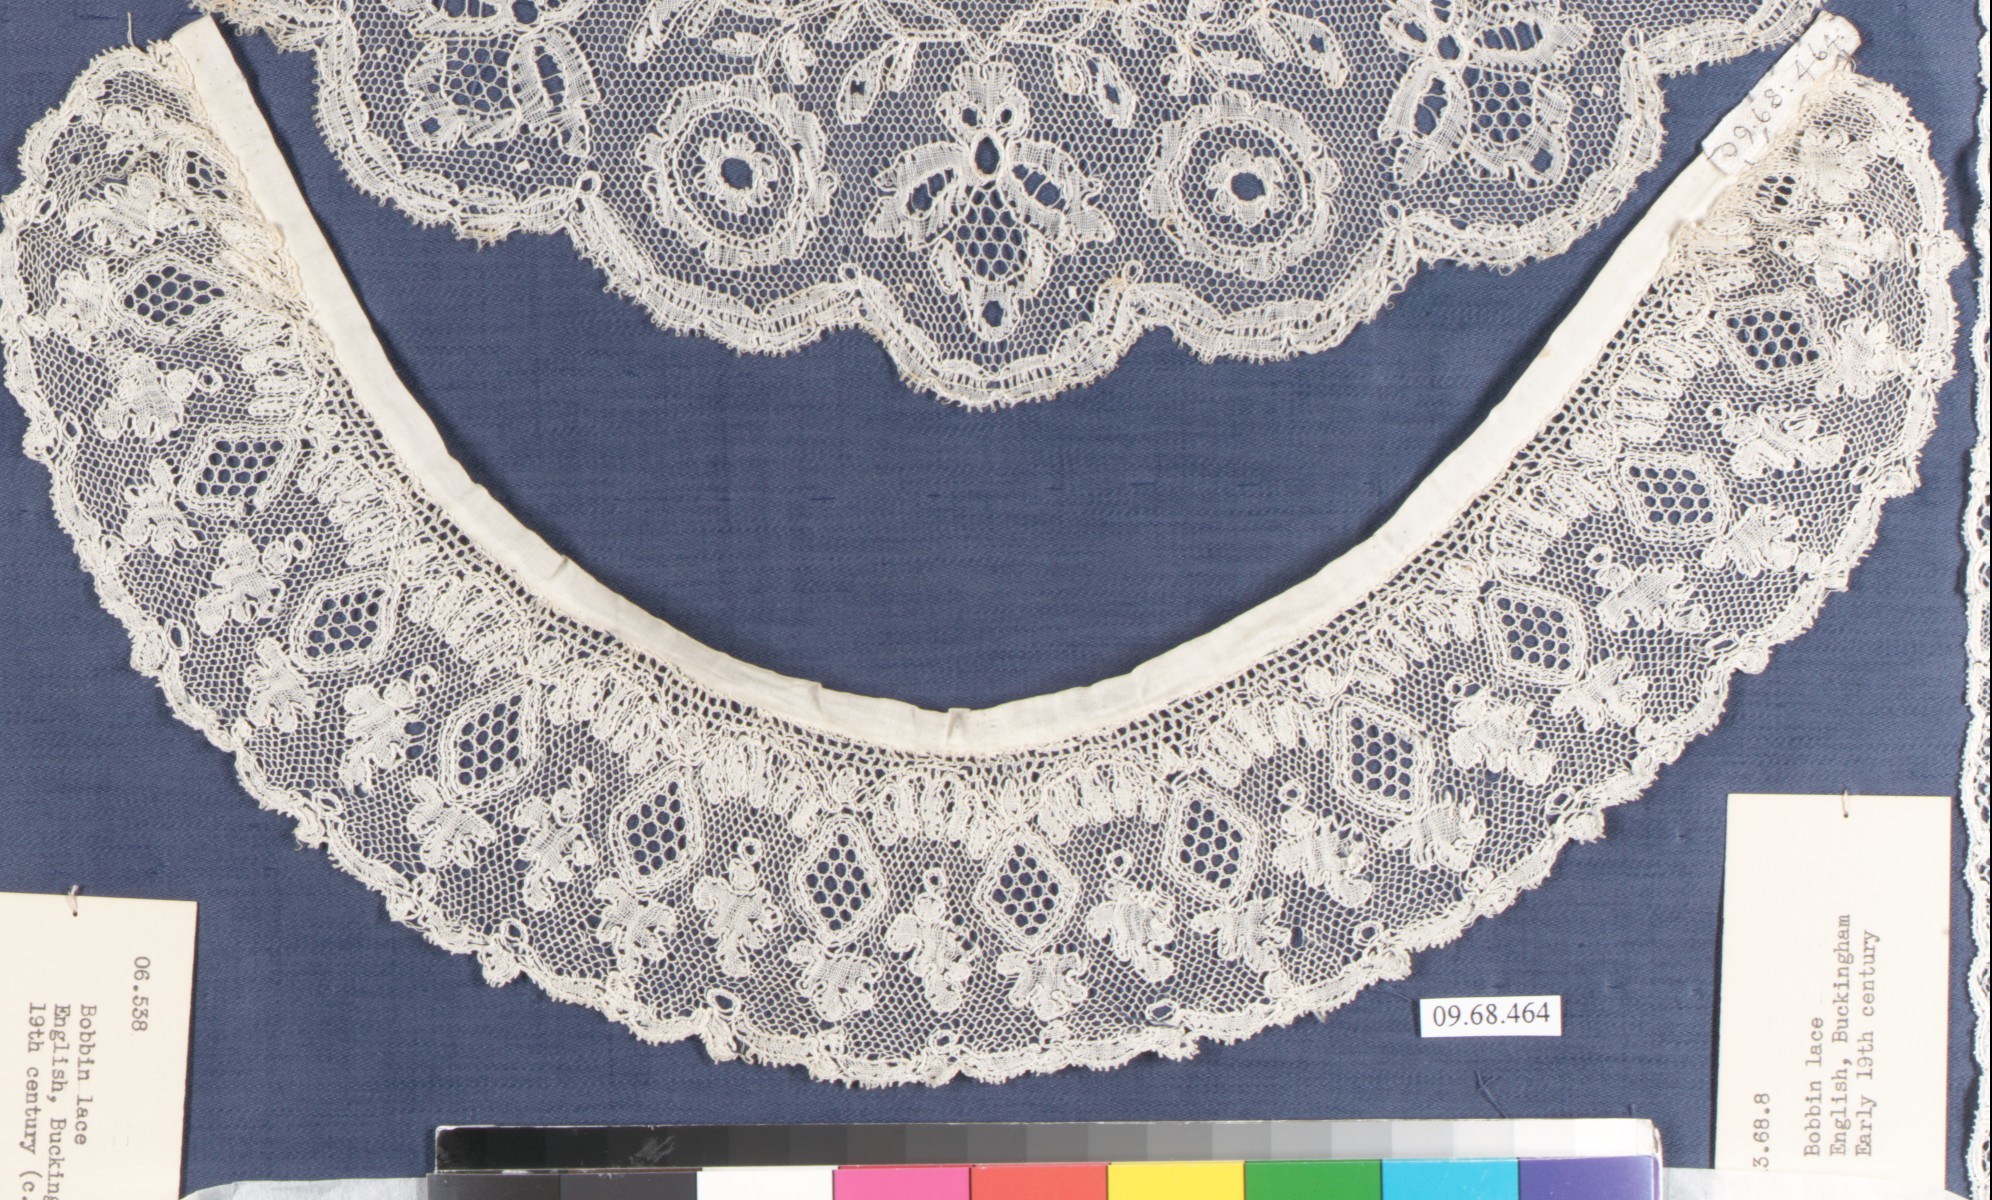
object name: collar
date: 1801-1900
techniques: lace